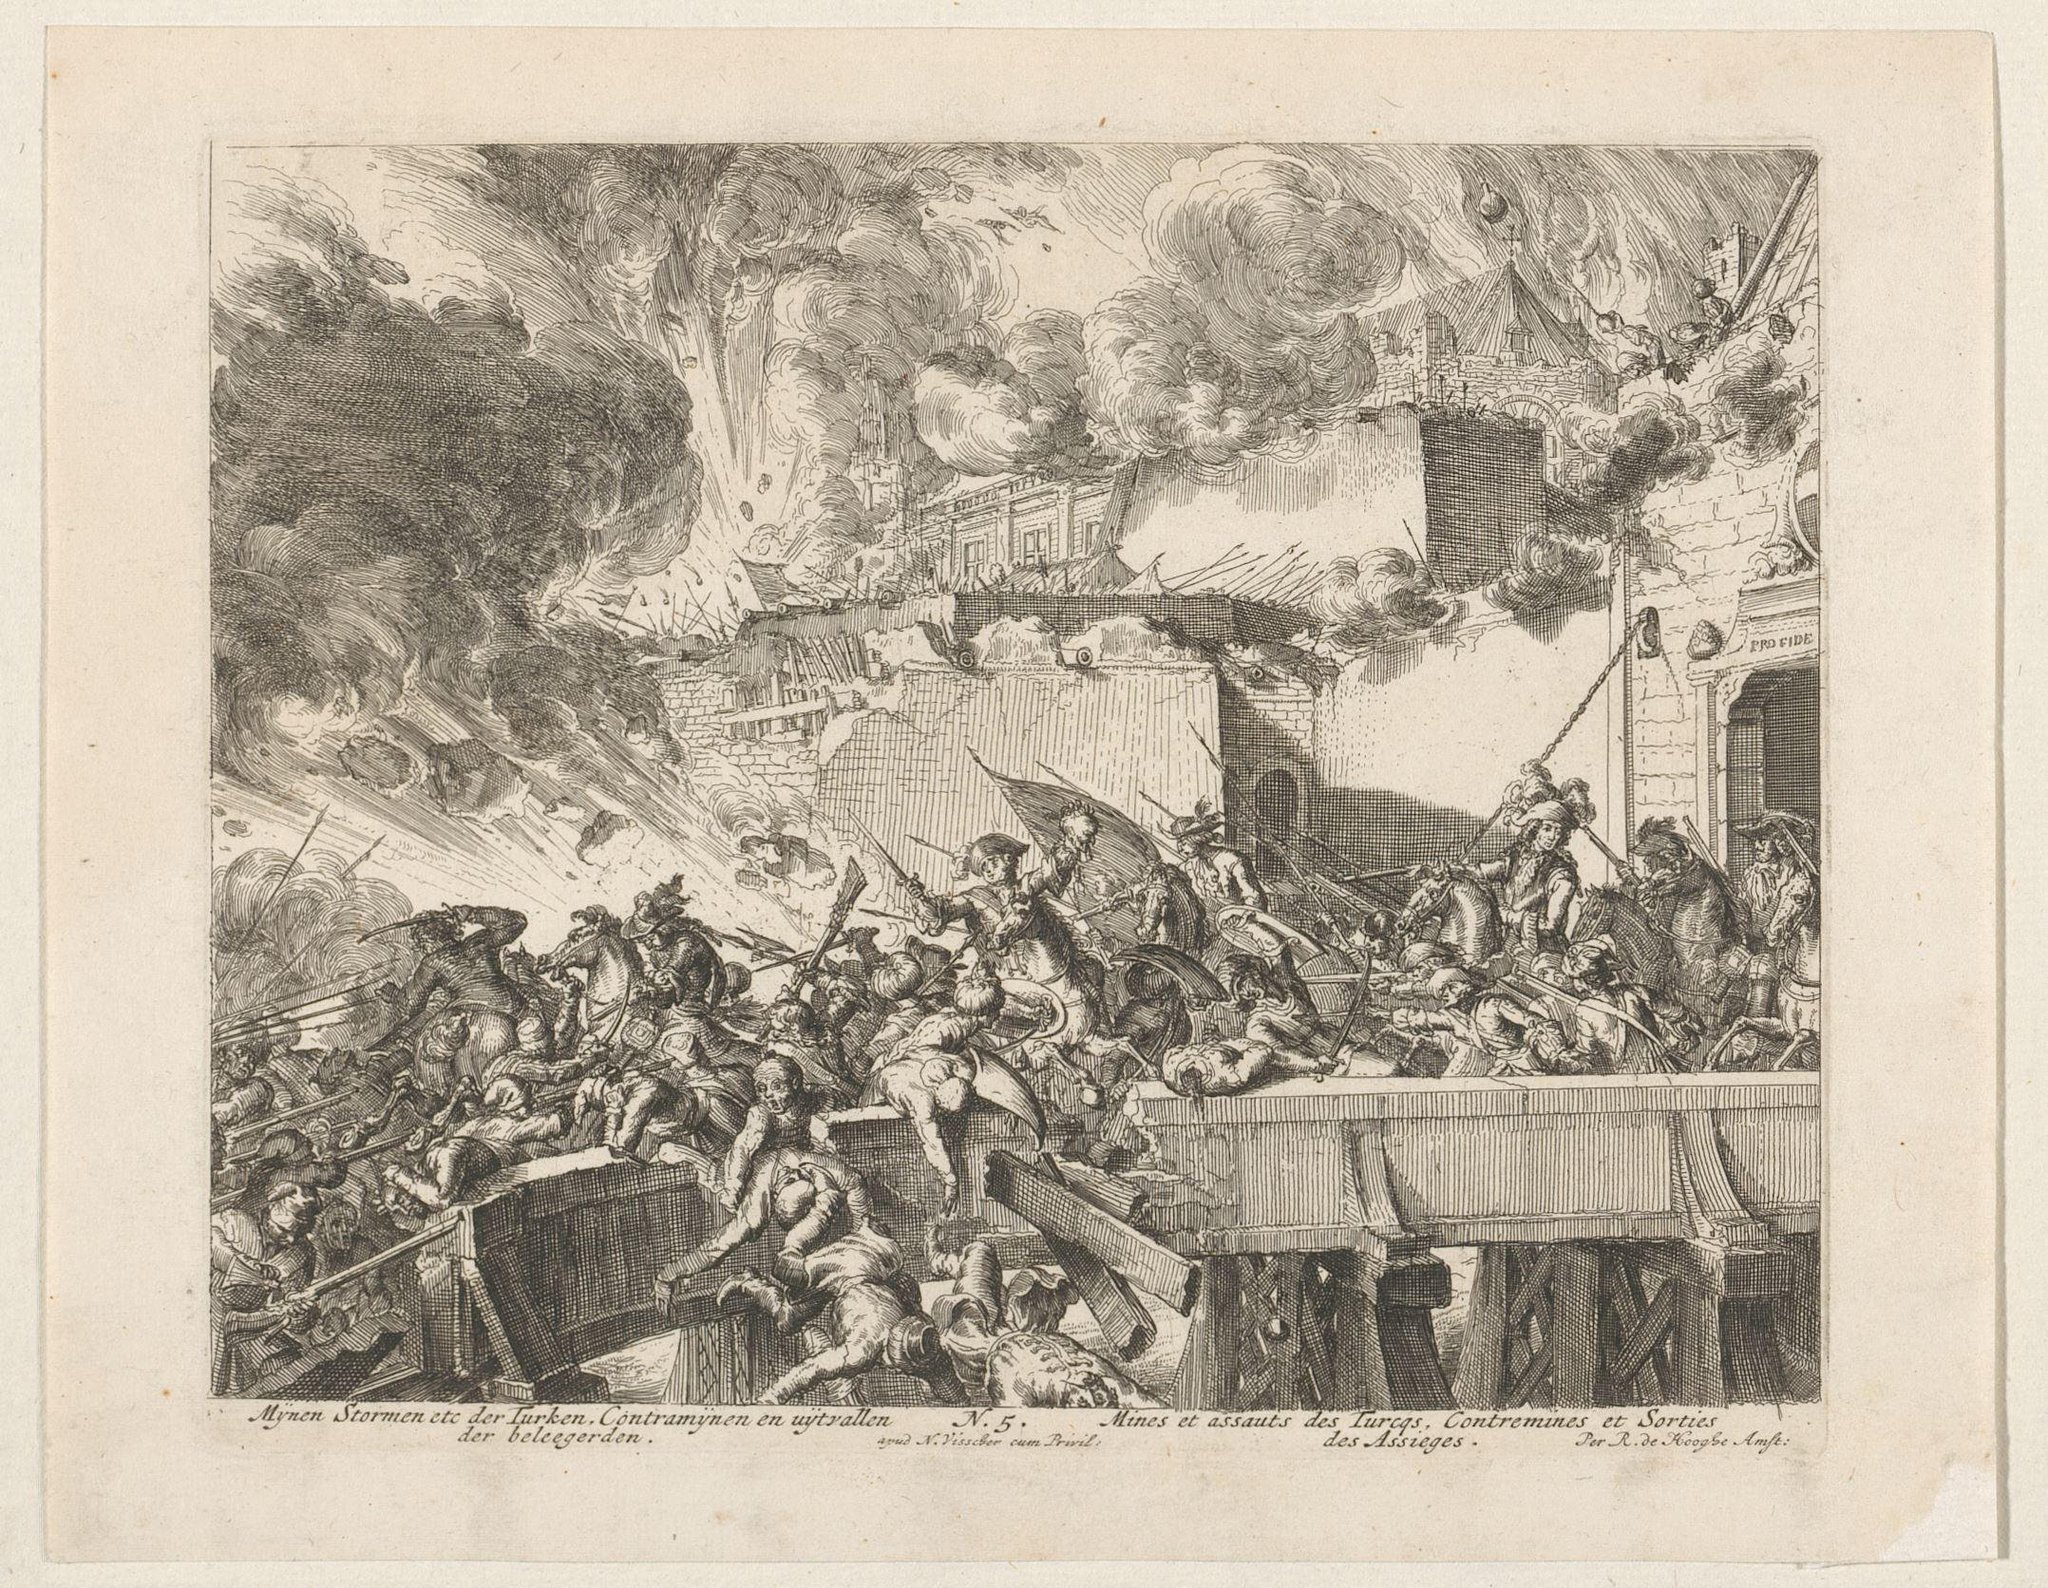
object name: print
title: Gevechten tussen Turkse belegeraars en Habsburgers op een brug bij een stadspoort van Wenen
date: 1684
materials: paper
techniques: etching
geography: amsterdam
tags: jan iii sobieski (koning van polen), vienna, leopold i (keizer van duitsland), siege, position war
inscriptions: collector's mark: Lugt 2228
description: Gevechten tussen Turkse belegeraars en Habsburgers op een brug bij een stadspoort van Wenen. Deze prent is nr. 5 in een serie prenten van tien voorstellingen over het ontzet van Wenen in 1683 voor 'Relation succinte et veritable de tout ce qui s'est passé pendant le Siege de Vienne etc.'